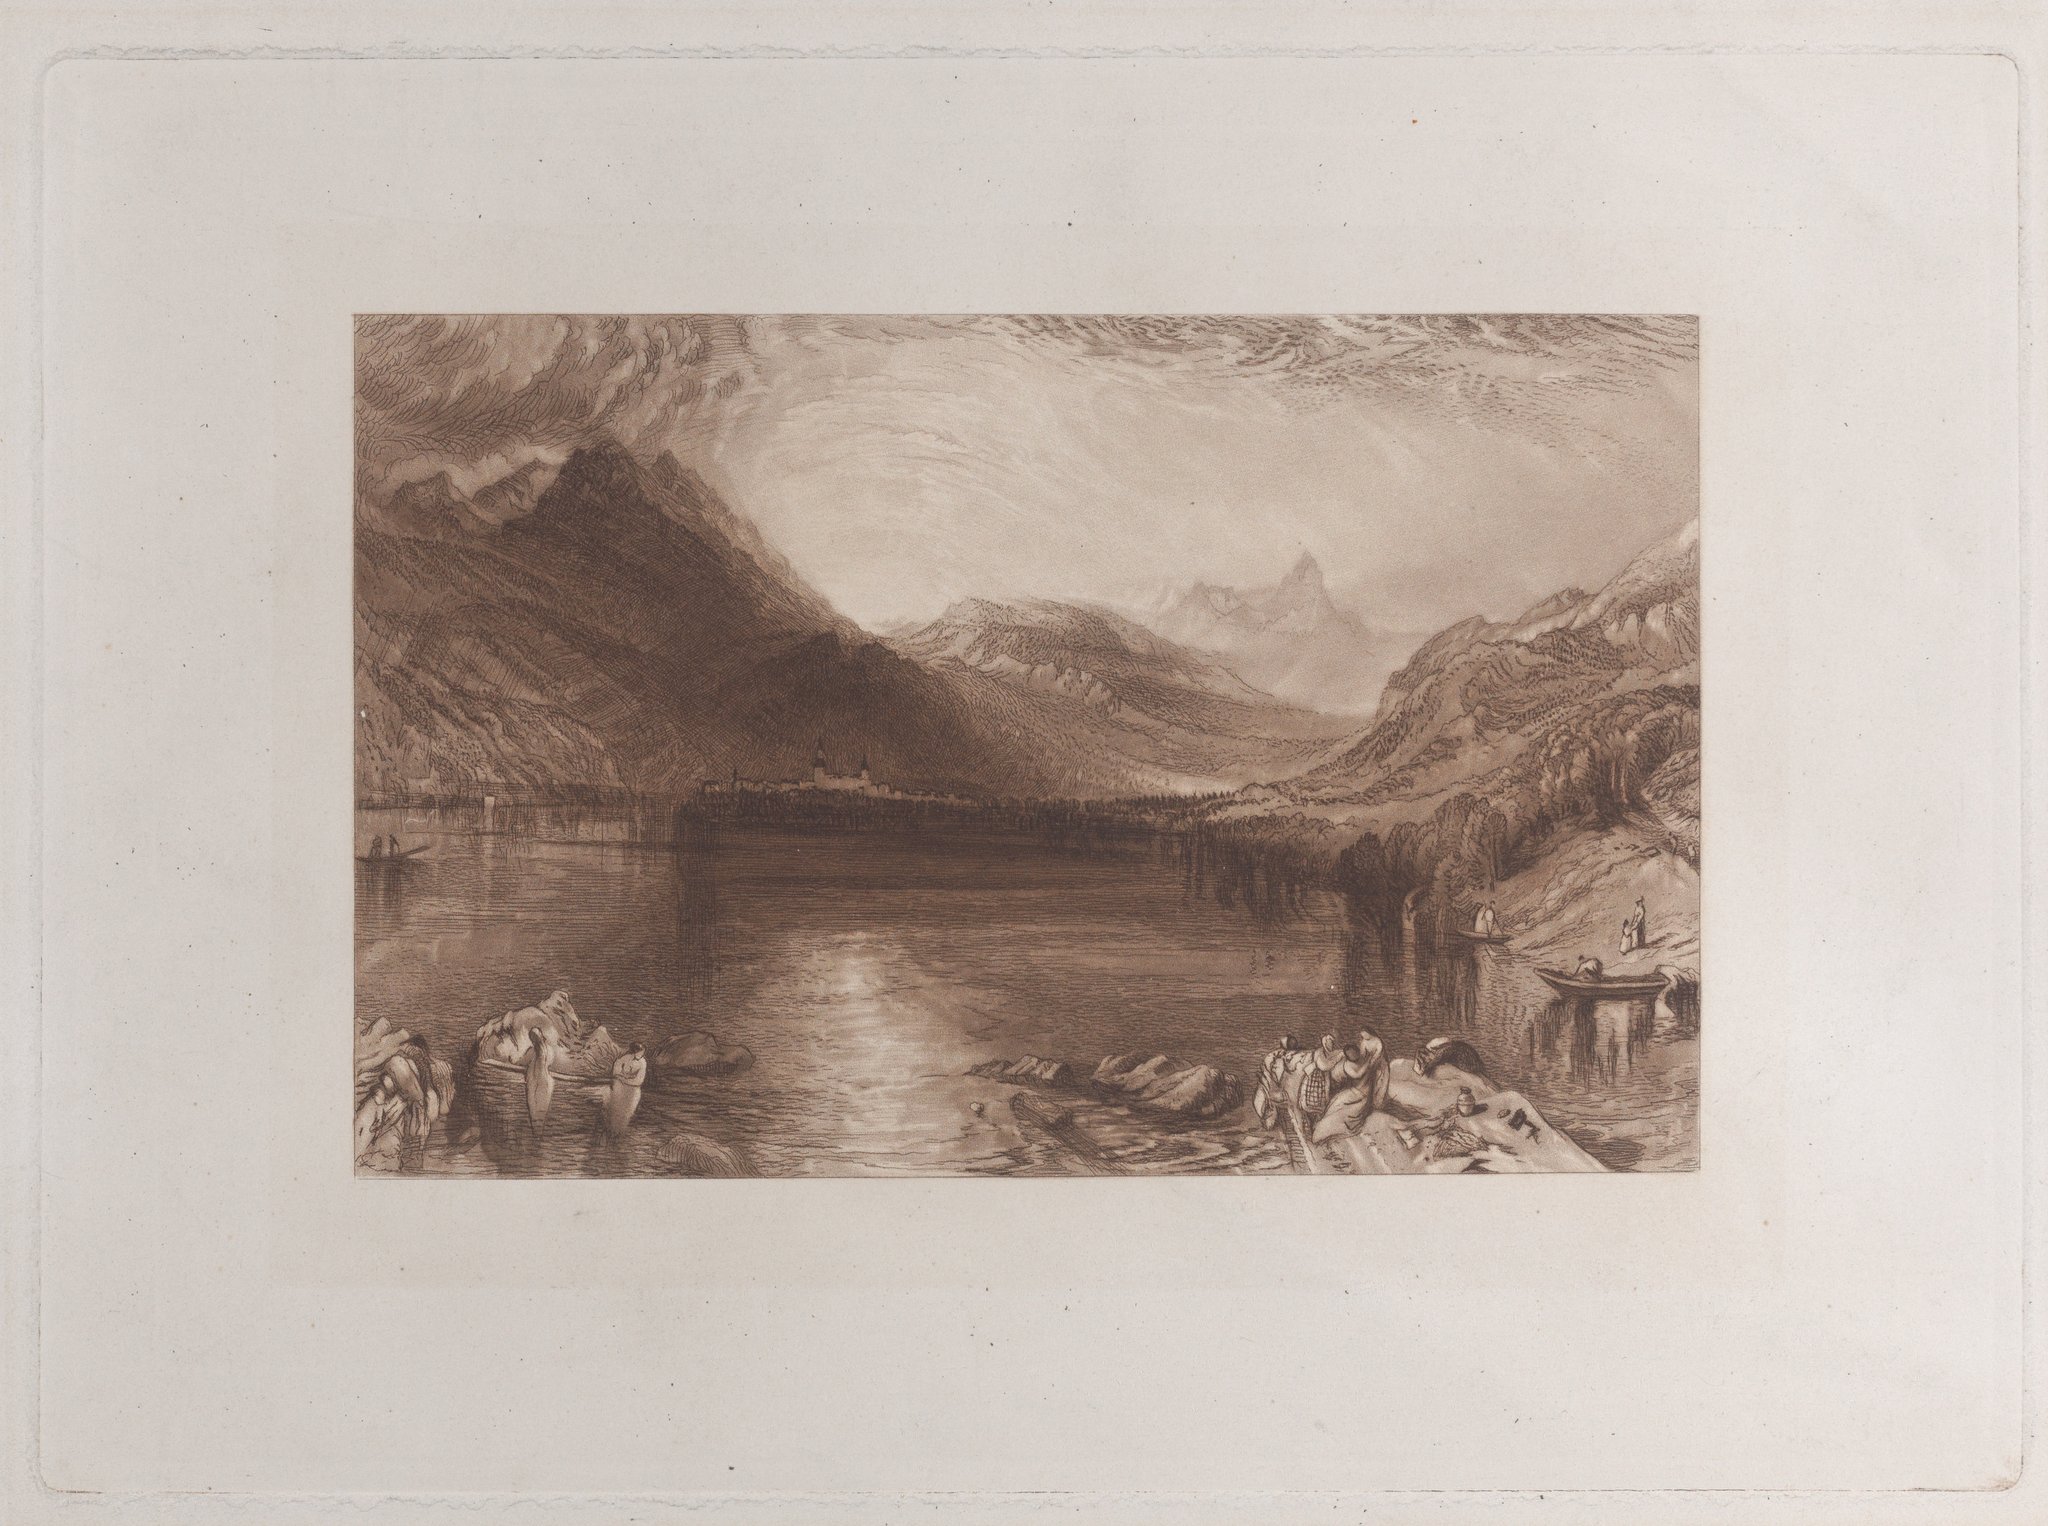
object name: print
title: The Lake of Zug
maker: john ruskin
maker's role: etcher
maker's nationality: british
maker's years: 1819-1900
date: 1888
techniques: etching, mezzotint